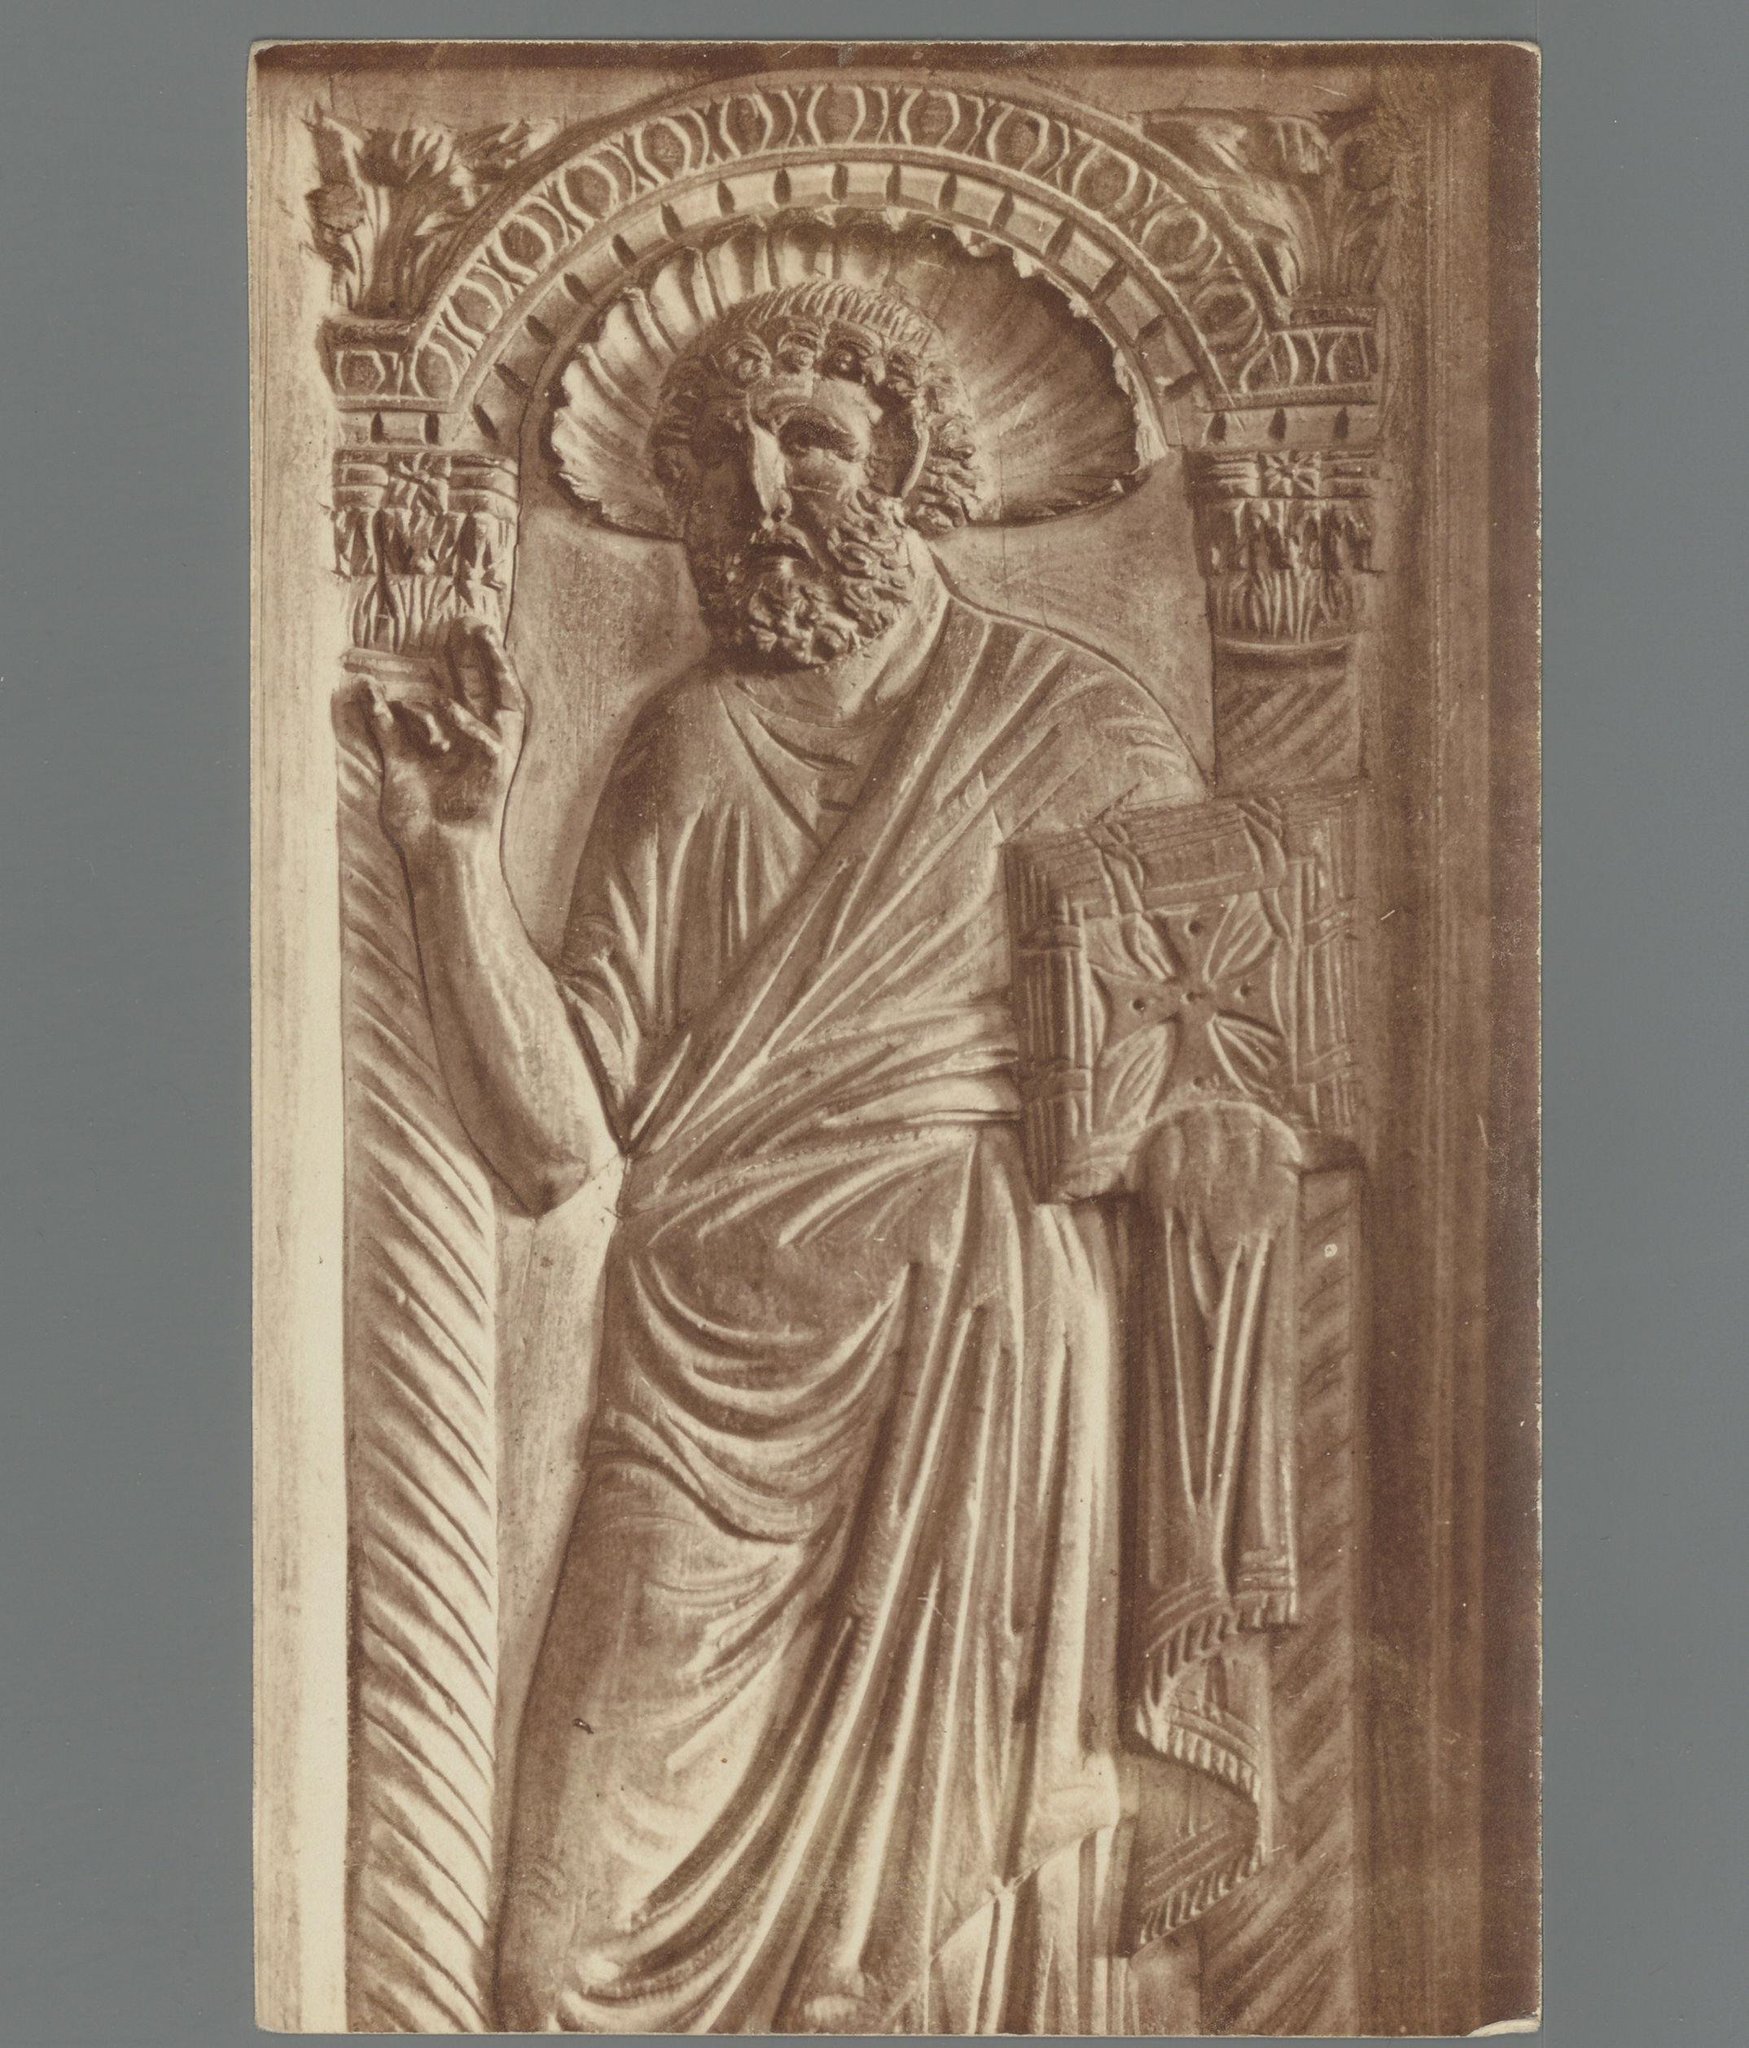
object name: photograph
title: Haut-reliëf van een evangelist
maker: l. ricci (fotograaf)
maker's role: fotograaf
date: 1906-1920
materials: photographic support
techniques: photography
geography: ravenna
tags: saints, sculpture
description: Het haut-reliëf is onderdeel van de troon van aartsbisschop Maximianus in de Basilica di San Vitale in Ravenna.